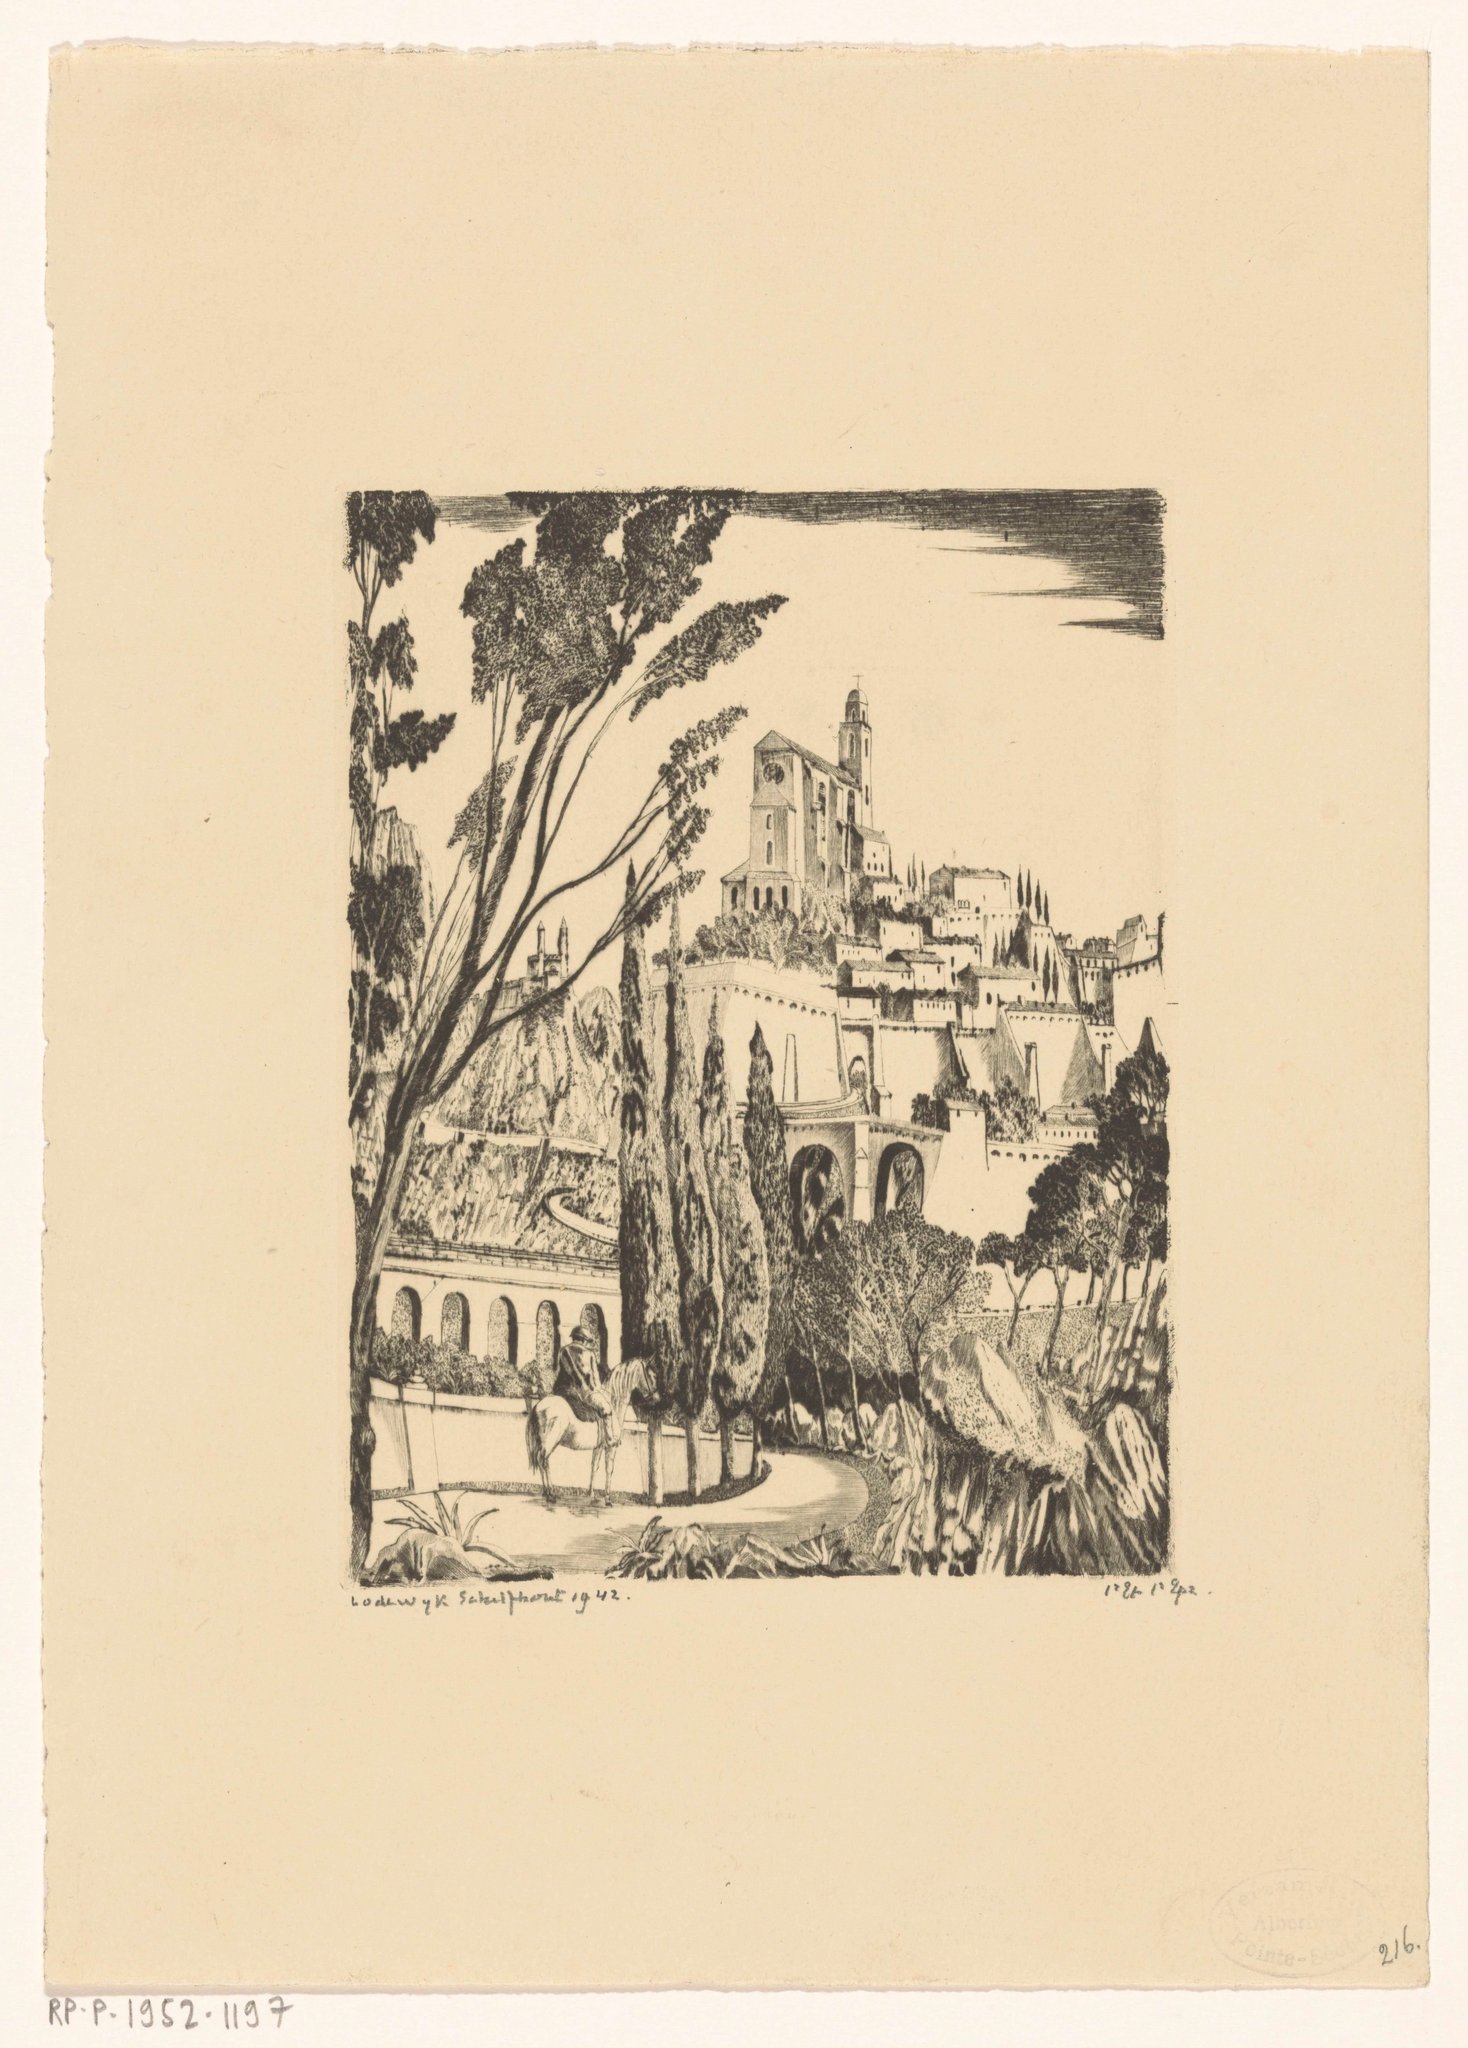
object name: print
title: Le Cavalier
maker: lodewijk schelfhout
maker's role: draughtsman, print maker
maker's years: 1881-1943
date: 1942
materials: paper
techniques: drypoint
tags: riding a horse, ass, or mule; rider, horseman, city-view, and landscape with man-made constructions, low hill country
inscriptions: collector's mark: Lugt 2228, collector's mark: Lugt 5i, collector's mark: Lugt 5i